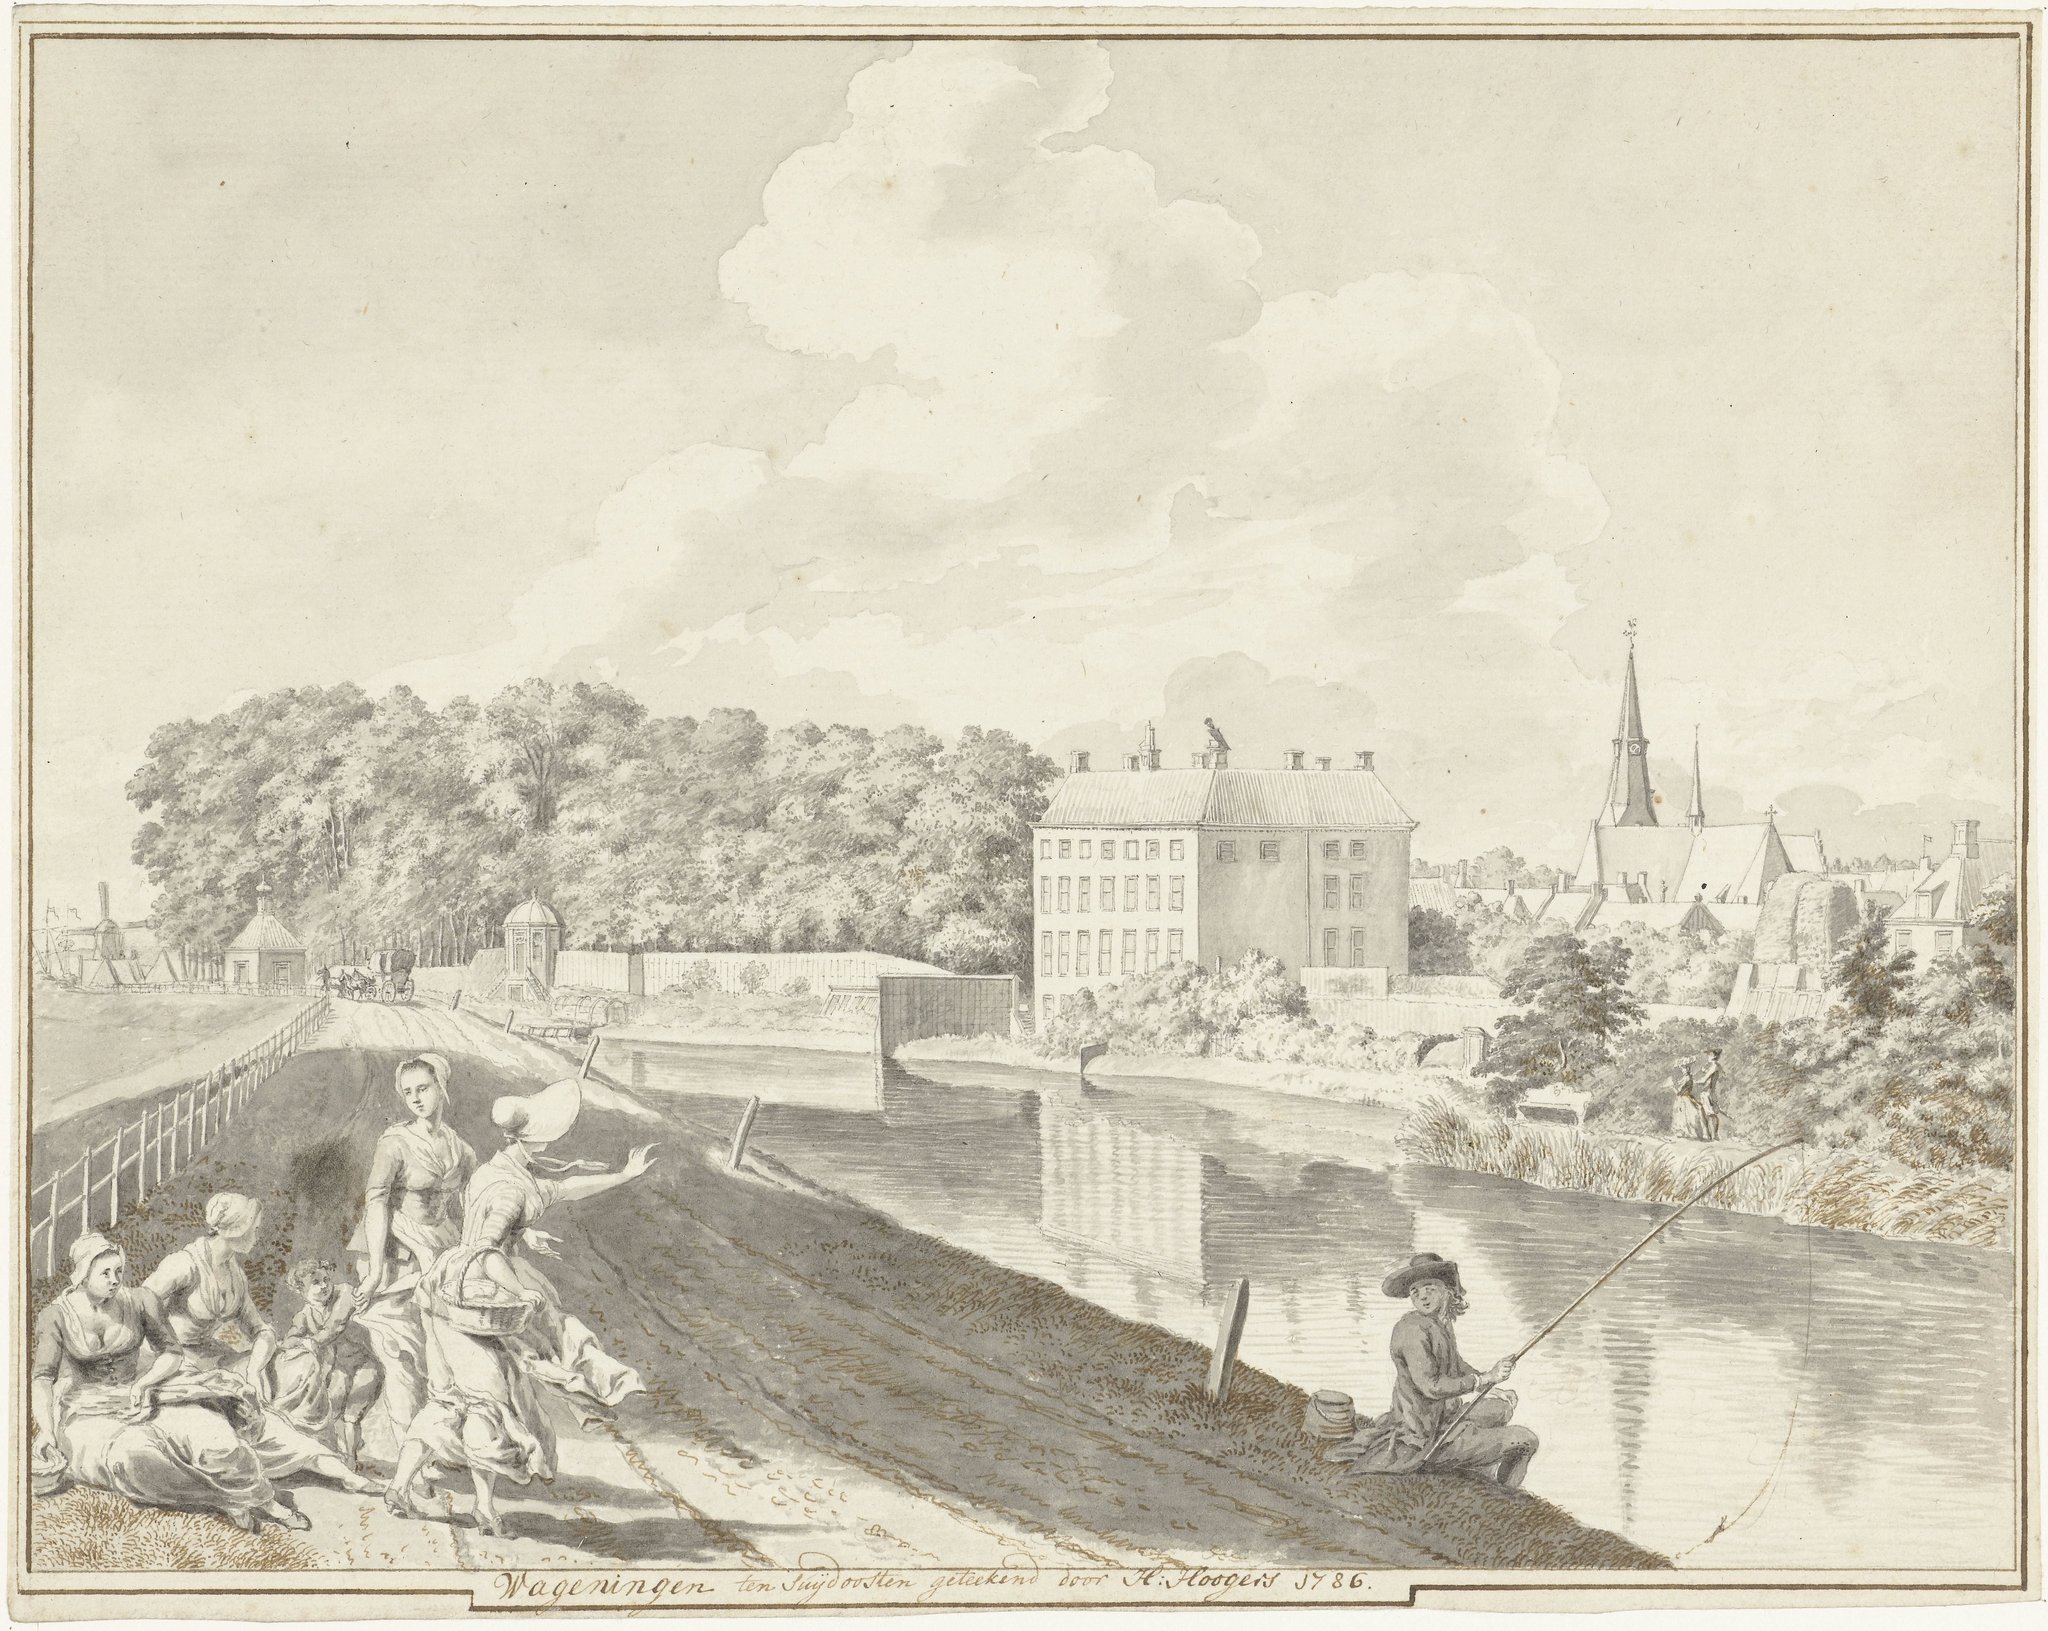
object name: drawing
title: Gezicht op Wageningen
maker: hendrik hoogers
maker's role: draughtsman, mayor, print maker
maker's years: 1747-1814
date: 1786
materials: ink, paper, pencil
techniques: brush, pen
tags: prospect of city, town panorama, silhouette of city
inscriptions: inscription: ‘Wageningen ten suijdoosten getekend’